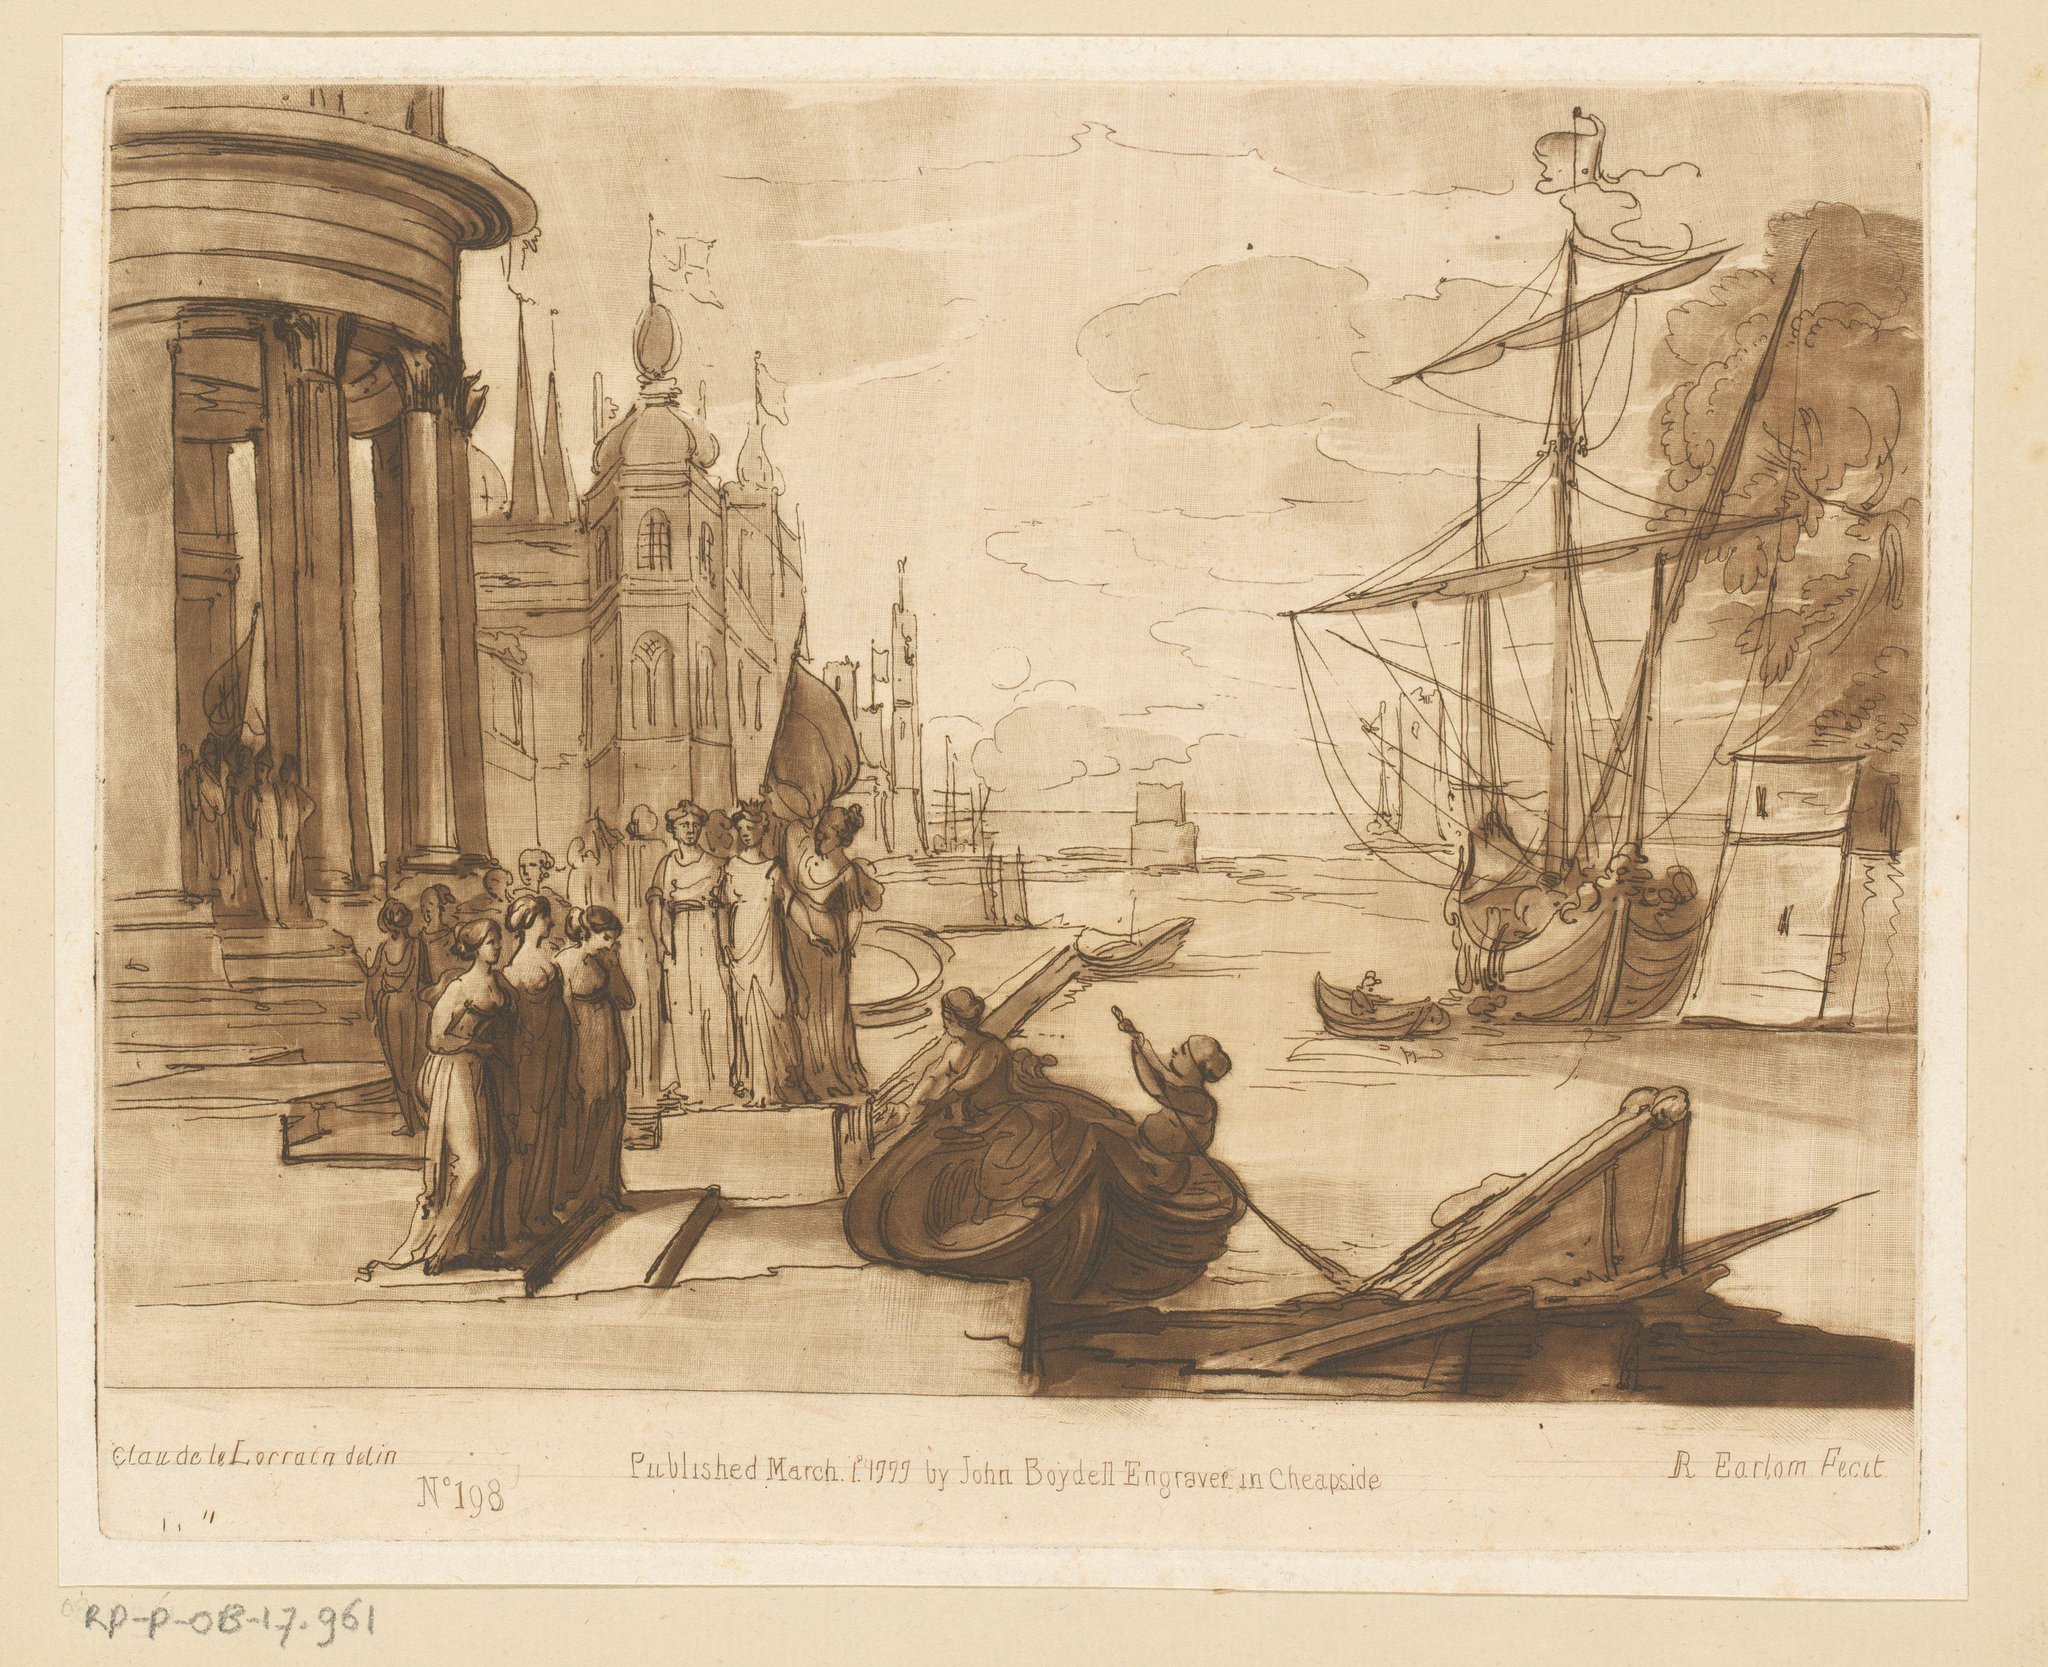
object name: print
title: Prenten naar tekeningen van Claude Lorrain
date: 1777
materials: paper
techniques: etching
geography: london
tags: harbour, city-view, and landscape with man-made constructions - ii - ideal landscapes, sea (seascape), ships (in general) (+ getting in; mounting; embarkation), the pilgrimage of st. ursula and her companions to rome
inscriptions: date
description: Vanaf 1774 publiceerde John Boydell tweehonderd prenten naar het tekeningenboek Liber Veritatis van Claude Lorrain, in het bezit van de hertogen van Cavendish. Deze prenten werden vanaf 1777 in twee volumes gebundeld uitgegeven.